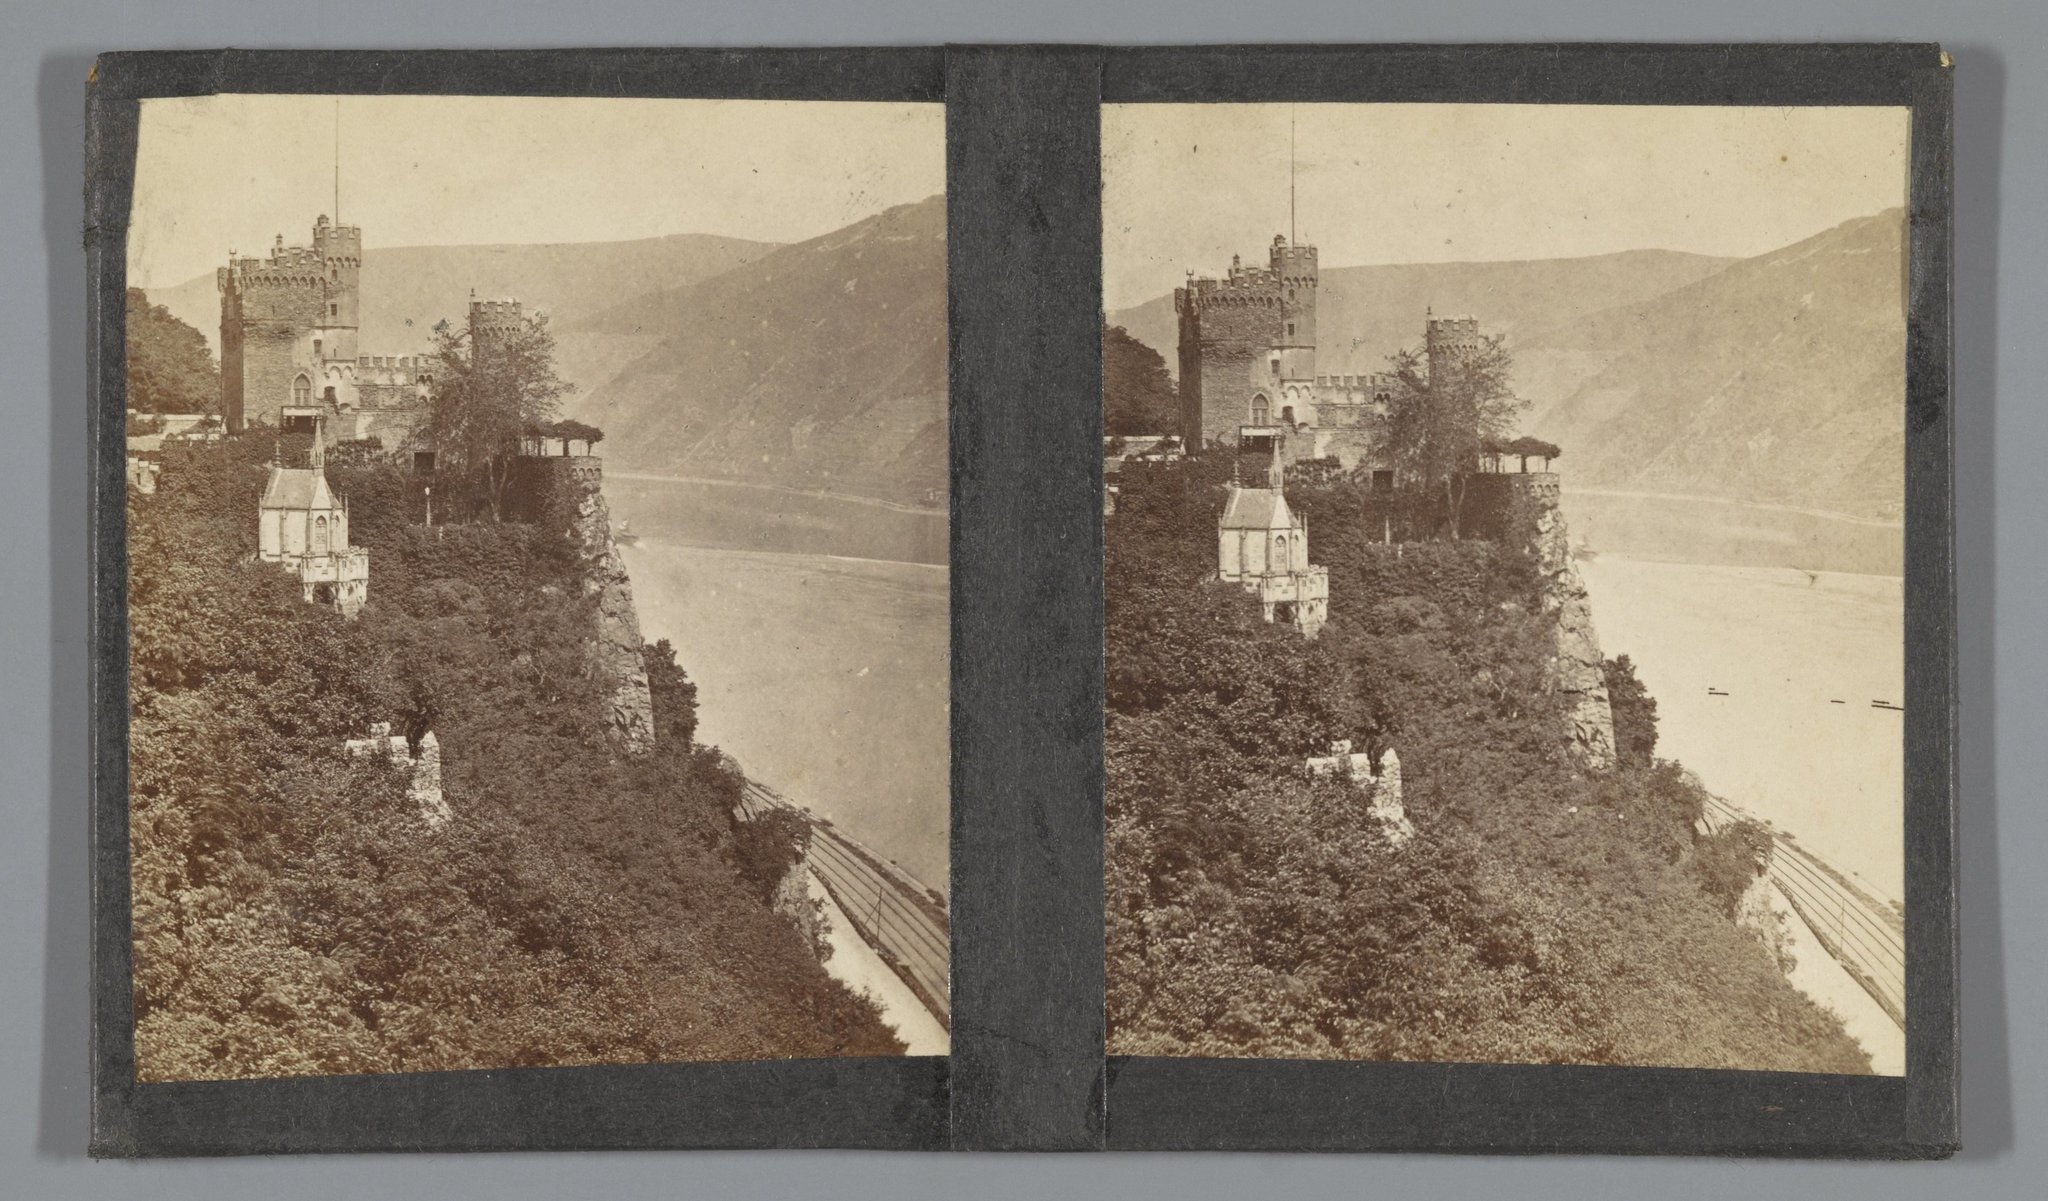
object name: stereograph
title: Burcht Rheinstein, Duitsland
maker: Anonymous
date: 1851-1880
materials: cardboard, paper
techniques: albumen print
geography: trechtingshausen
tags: castle, river, landscape with tower or castle